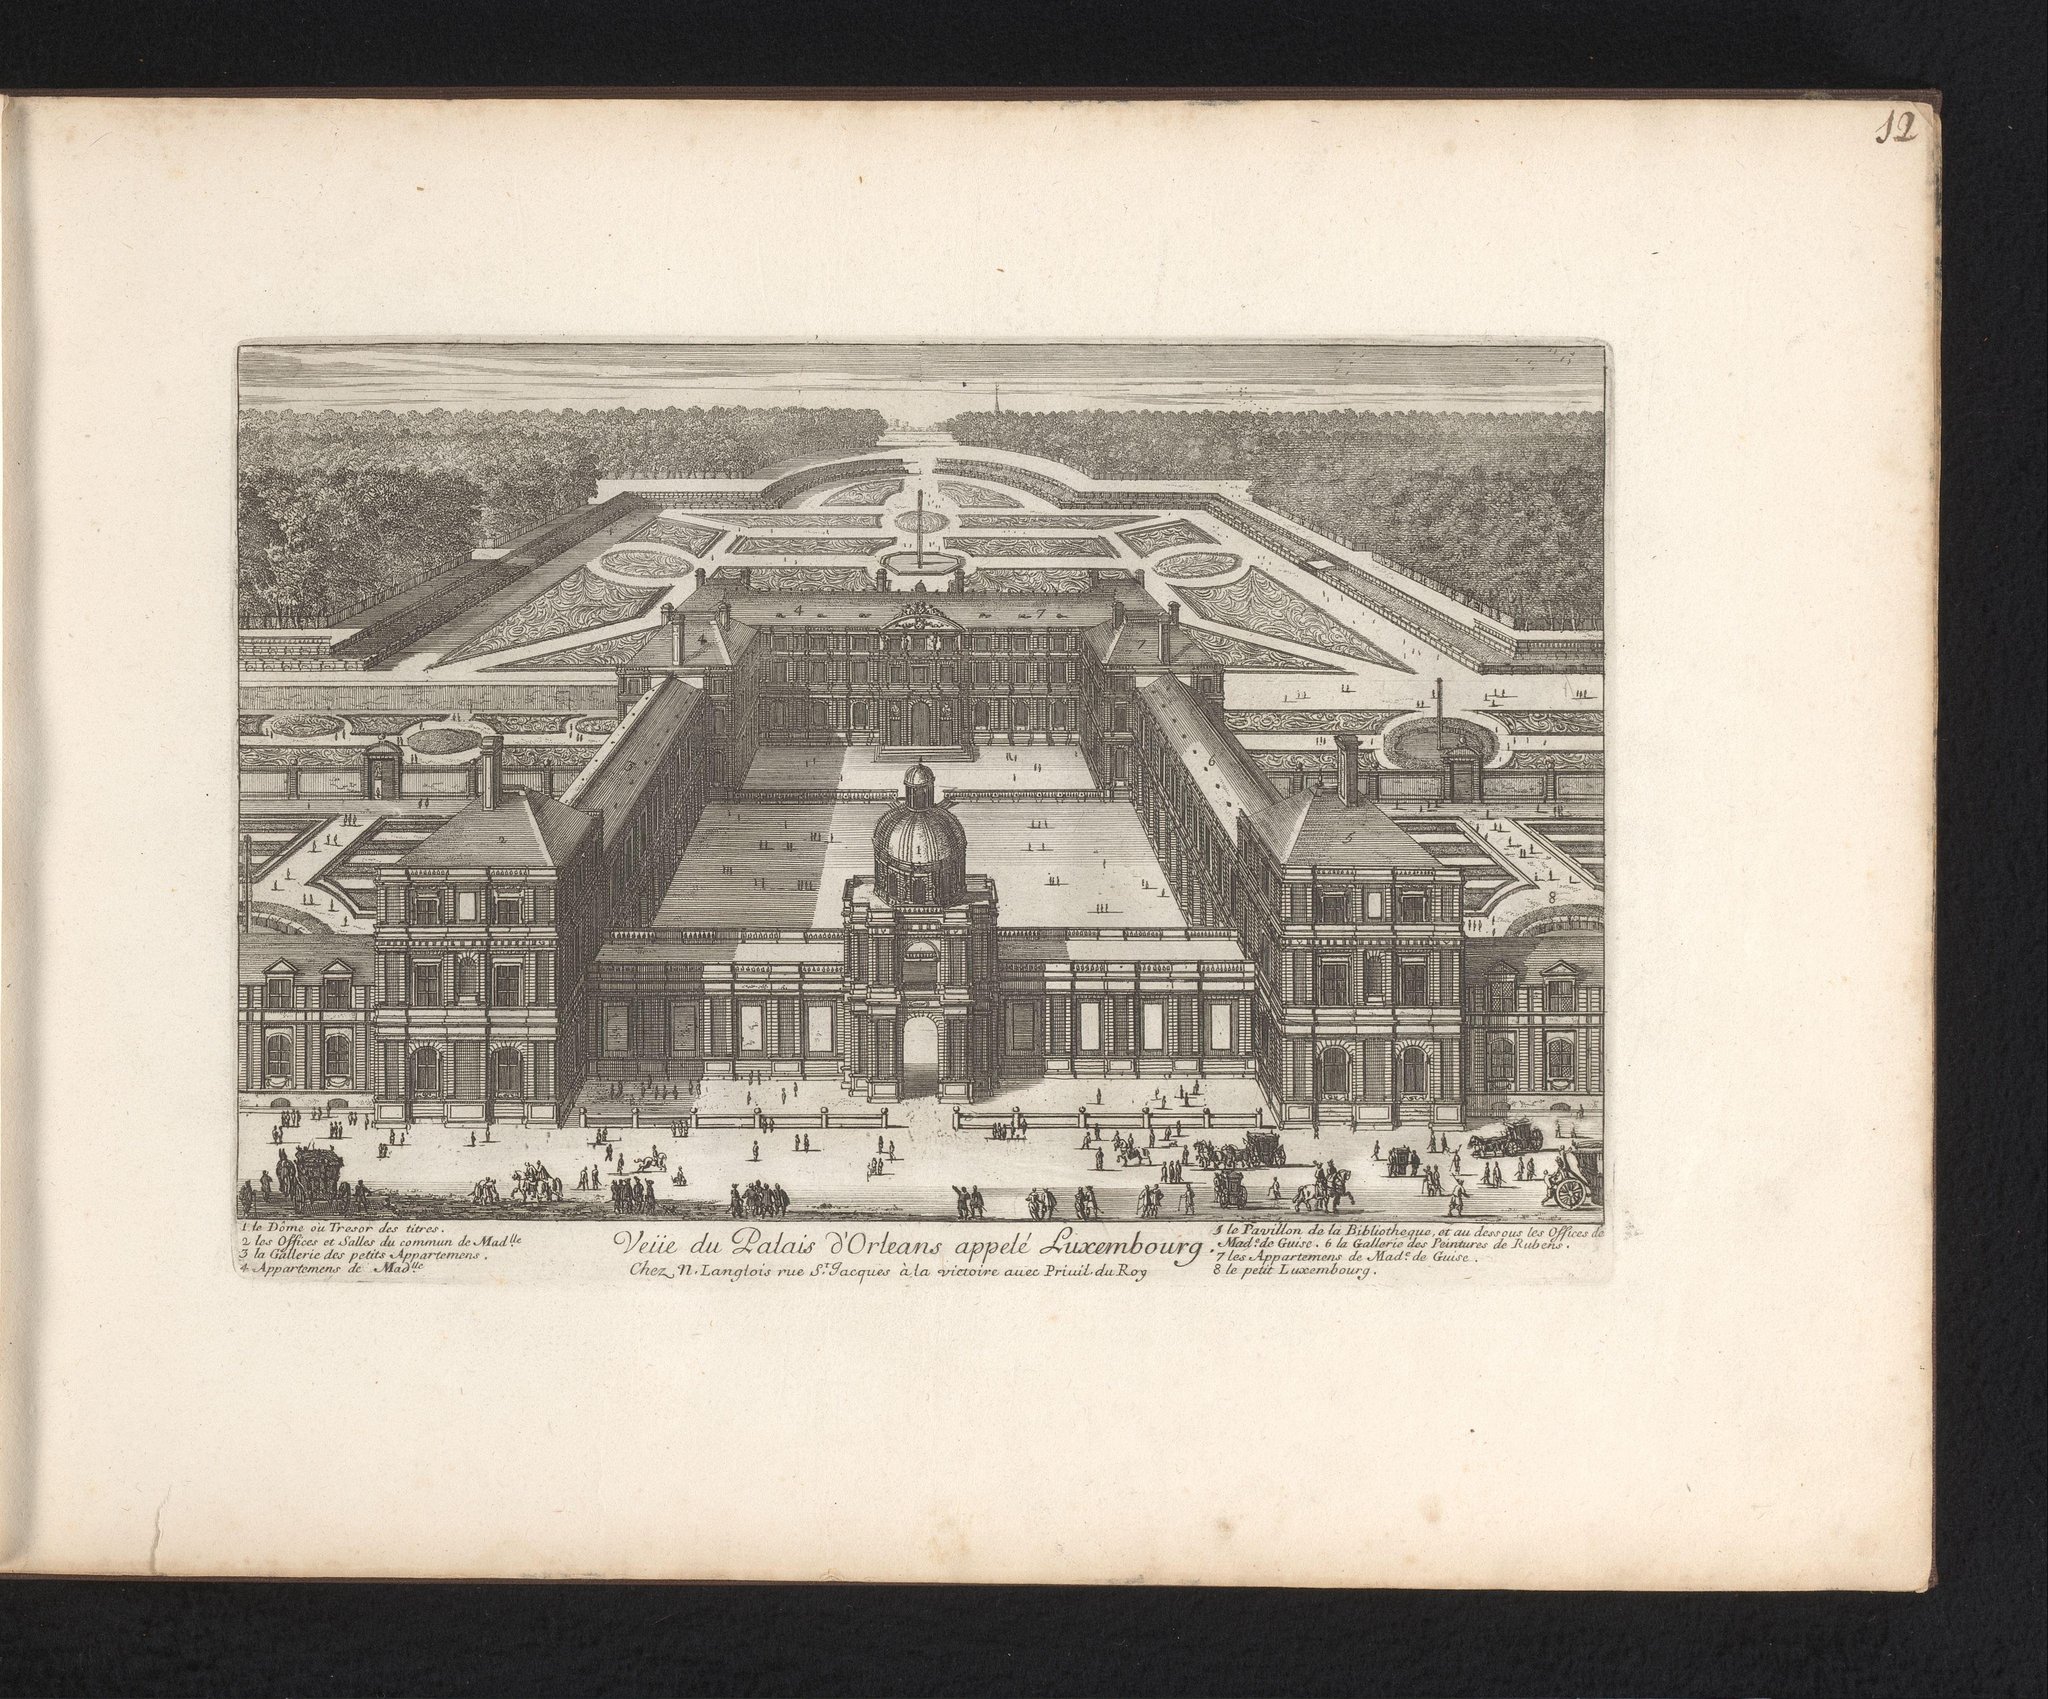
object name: print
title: Stadsgezichten en landschappen in Frankrijk en Italië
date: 1660-1695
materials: paper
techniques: etching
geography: paris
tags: palace, french or architectonic garden; formal garden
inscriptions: collector's mark: Lugt 2228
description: Prenten met het signatuur 'Perelle' kunnen zowel door vader Gabriel als door zonen Nicolas en Adam gemaakt zijn. De uitgevers vader en zoon Nicolas Langlois worden allebei vermeld als N. Langlois op hetzelfde adres.